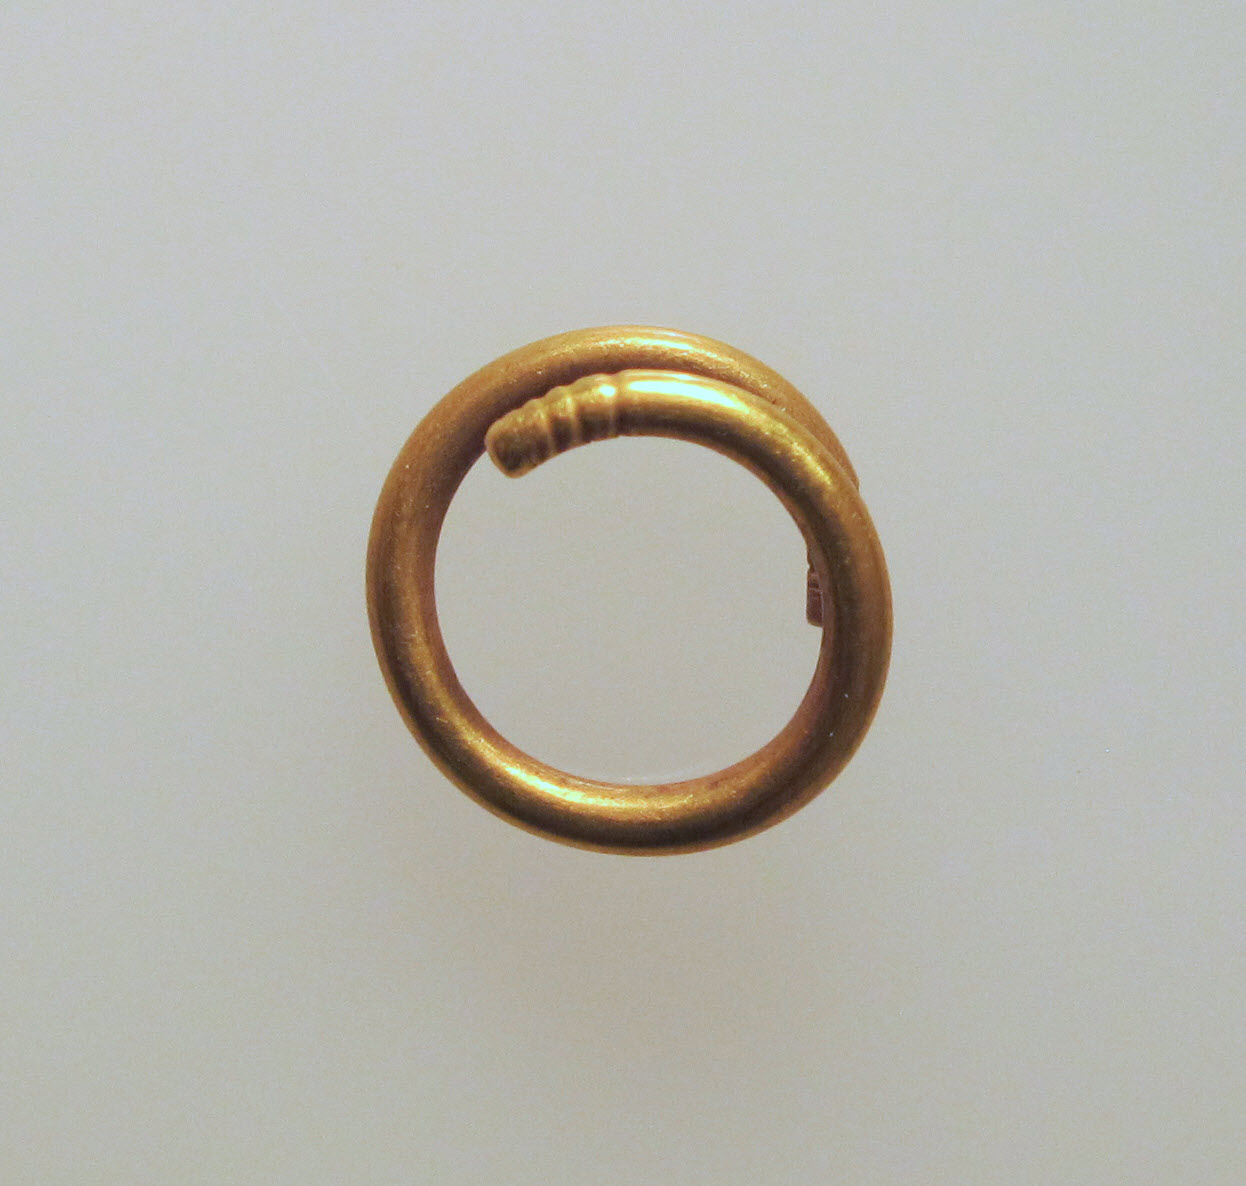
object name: spiral, 18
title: Spirals, 18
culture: cypriot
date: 3900 BCE-100 CE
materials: gold